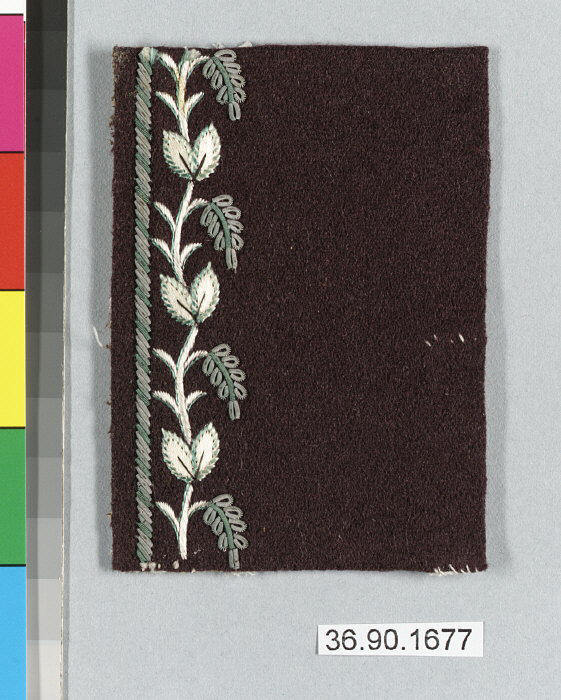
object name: sample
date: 1801-1833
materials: felt, metal thread, silk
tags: leaves